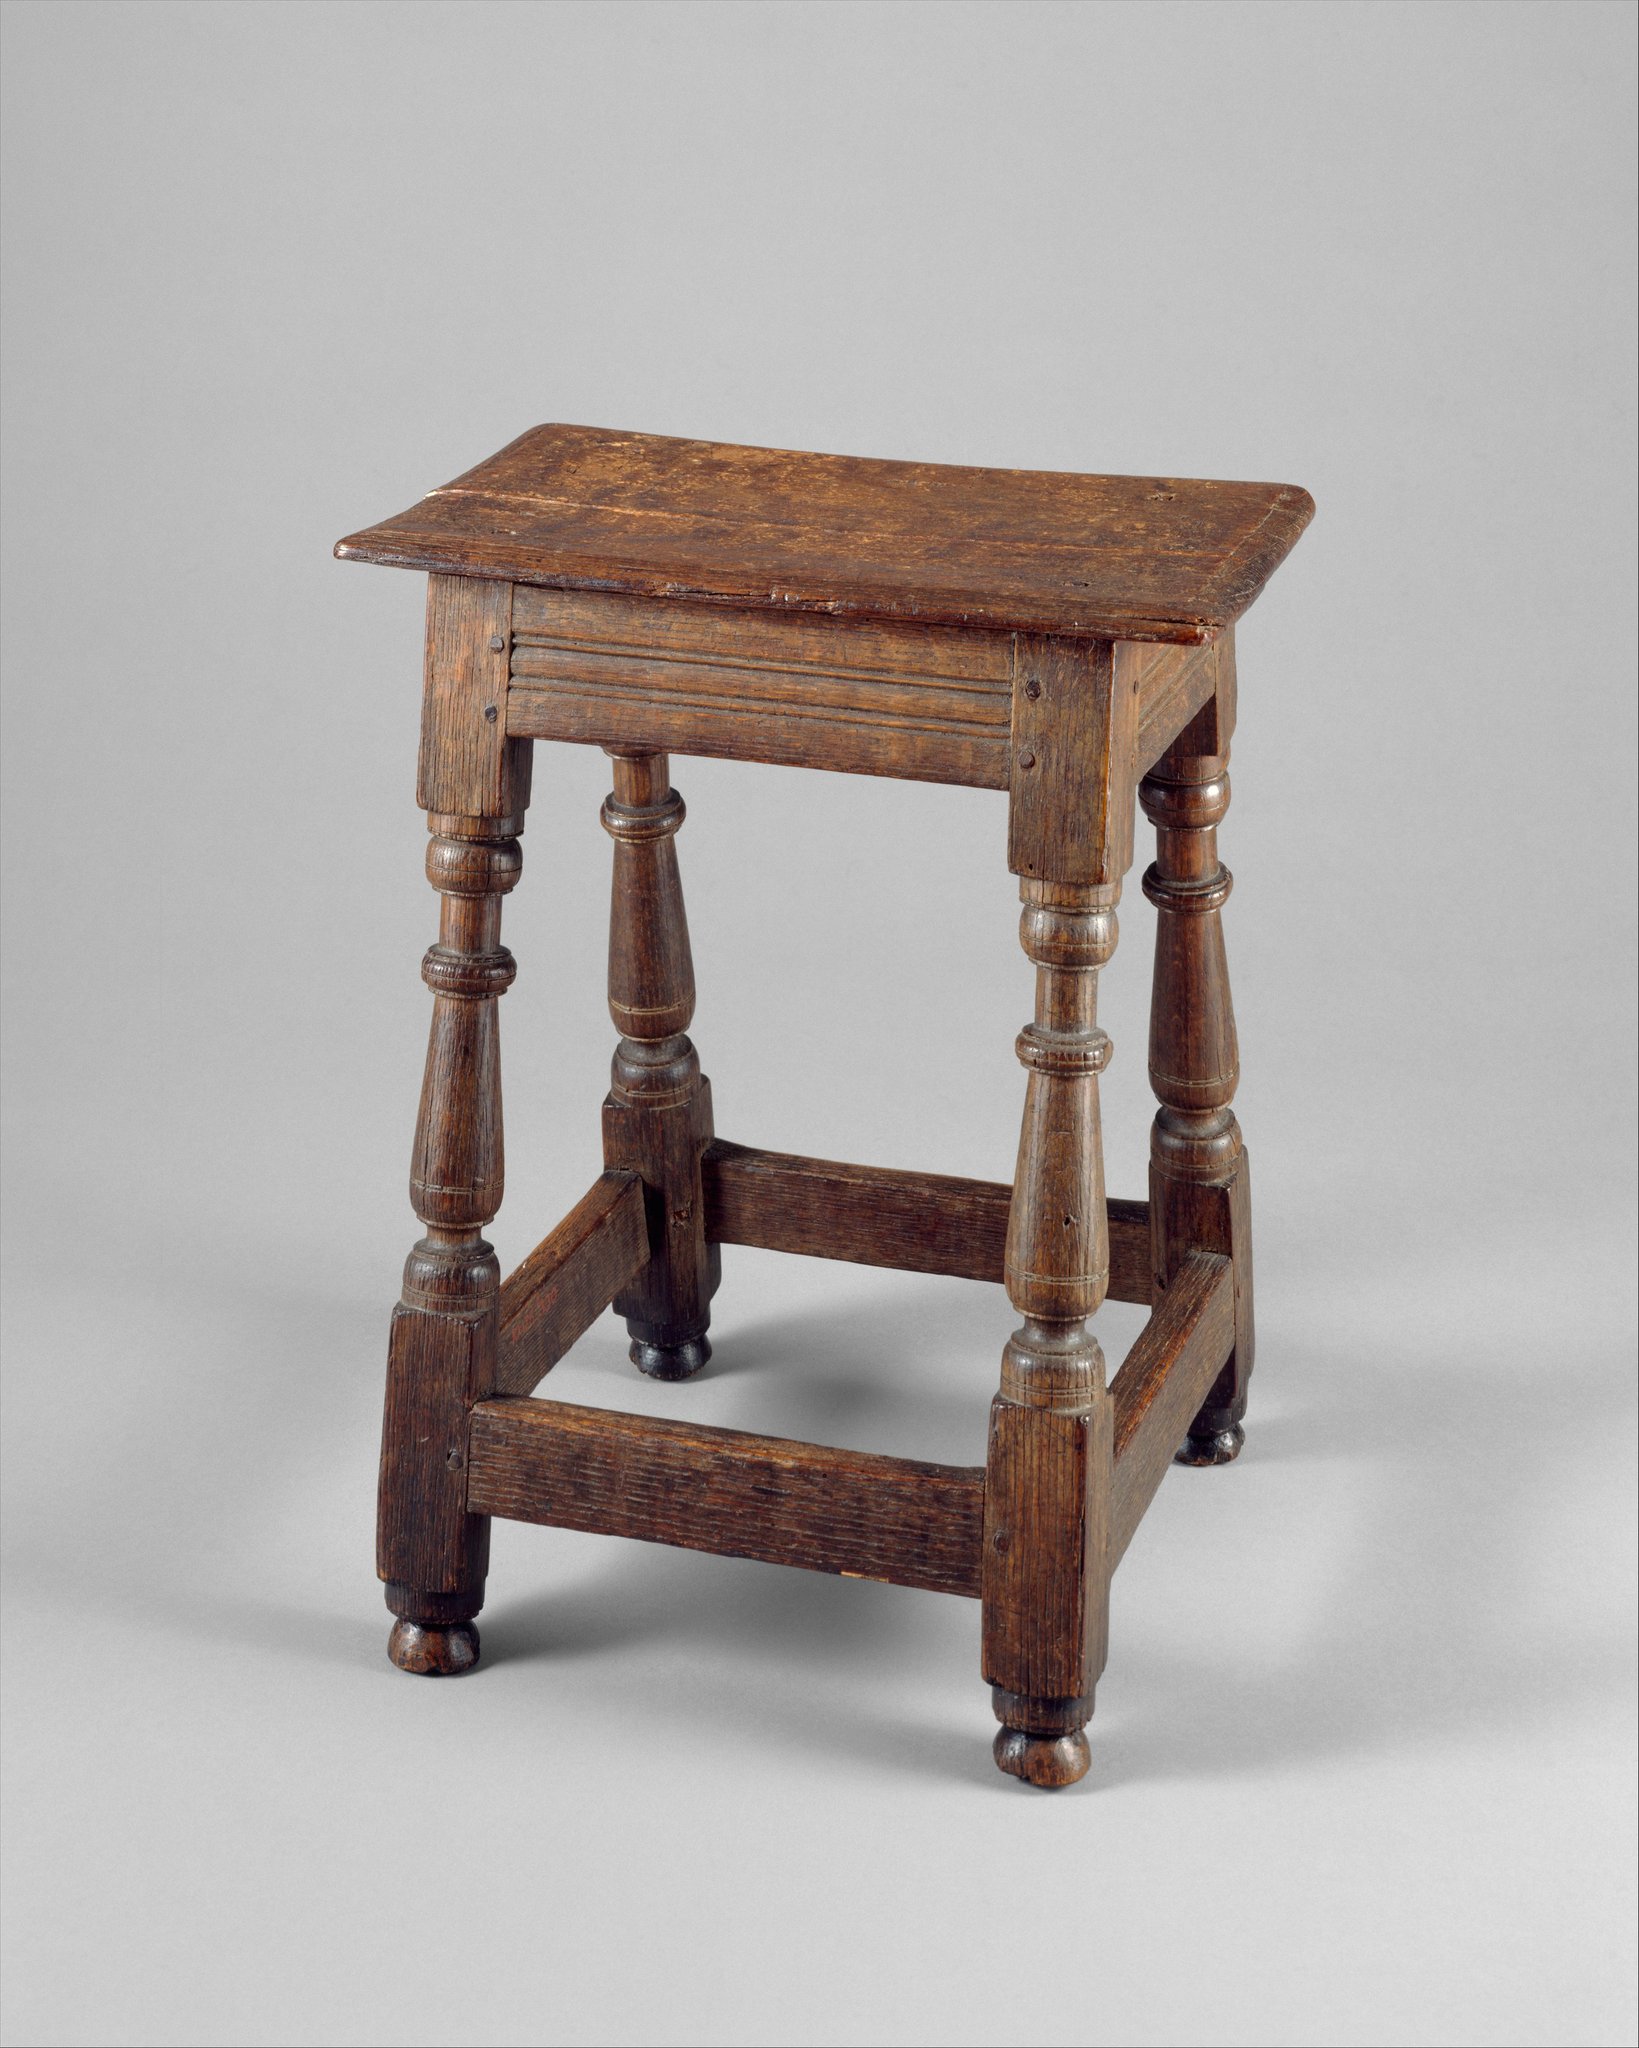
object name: joint stool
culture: american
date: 1650-1690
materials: wood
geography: united states